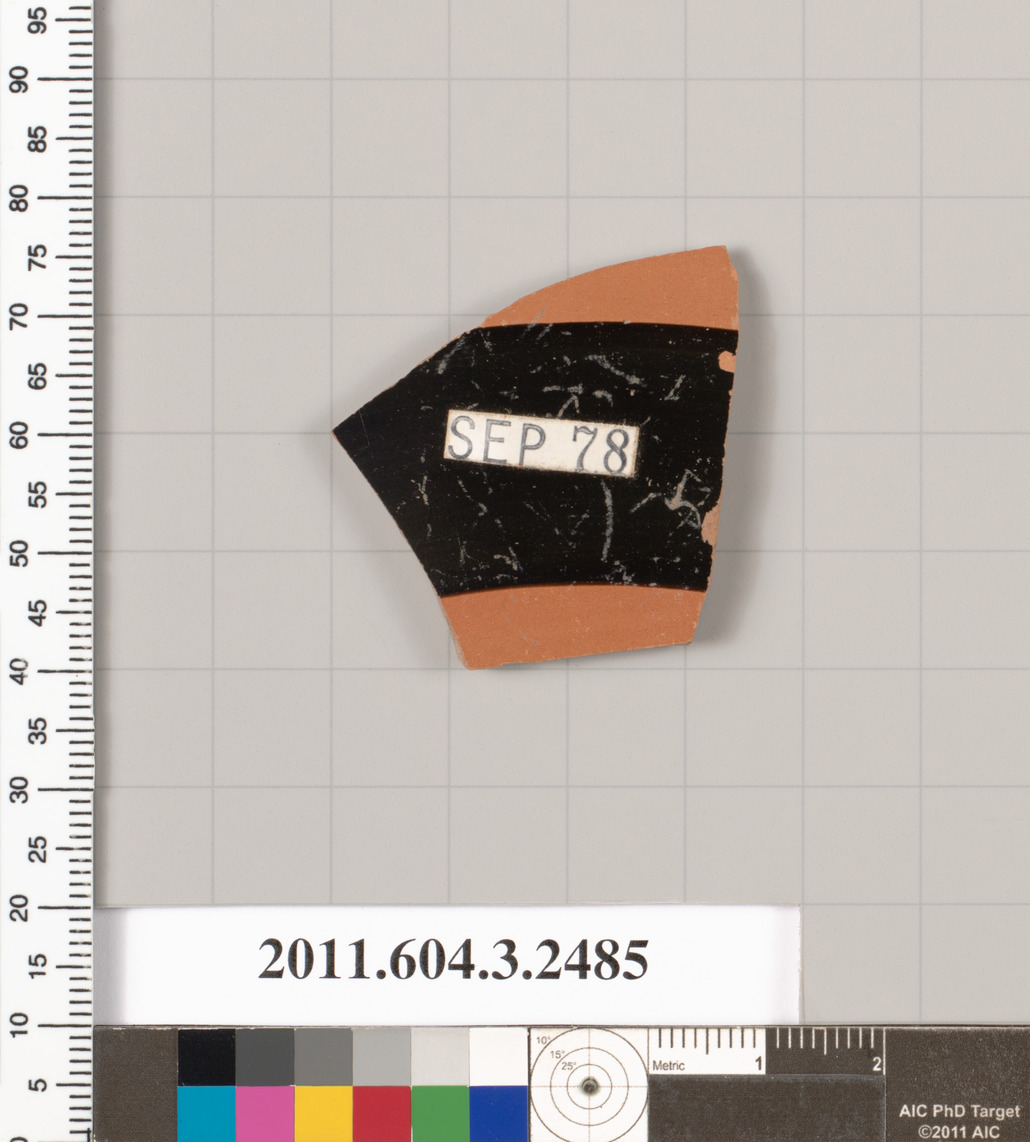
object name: kylix fragment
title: Terracotta fragment of a kylix (drinking cup)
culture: greek, attic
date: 600-401 BCE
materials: terracotta